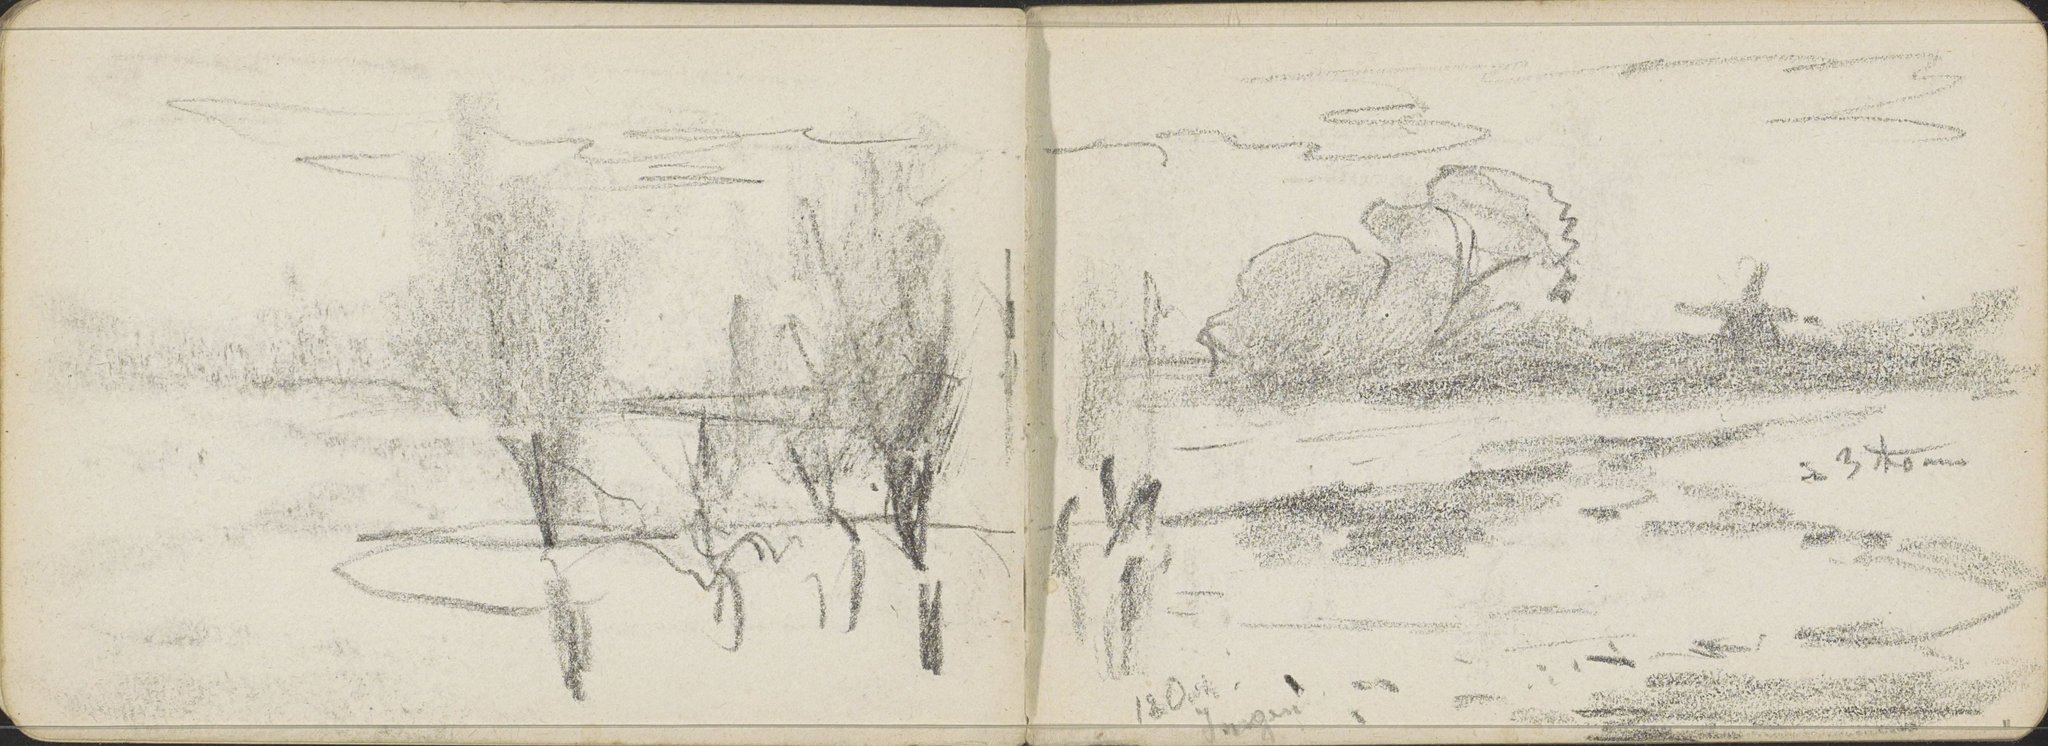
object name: sketchbook leaf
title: Landschap bij Ingen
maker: willem cornelis rip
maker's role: draughtsman, painter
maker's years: 1856-1922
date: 1905-1910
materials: chalk, paper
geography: ingen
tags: windmill in landscape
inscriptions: date and inscription: ‘[...]/ 12 Oct/ Ingen’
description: Blad 10 verso en 11 recto uit een schetsboek met 42 bladen.